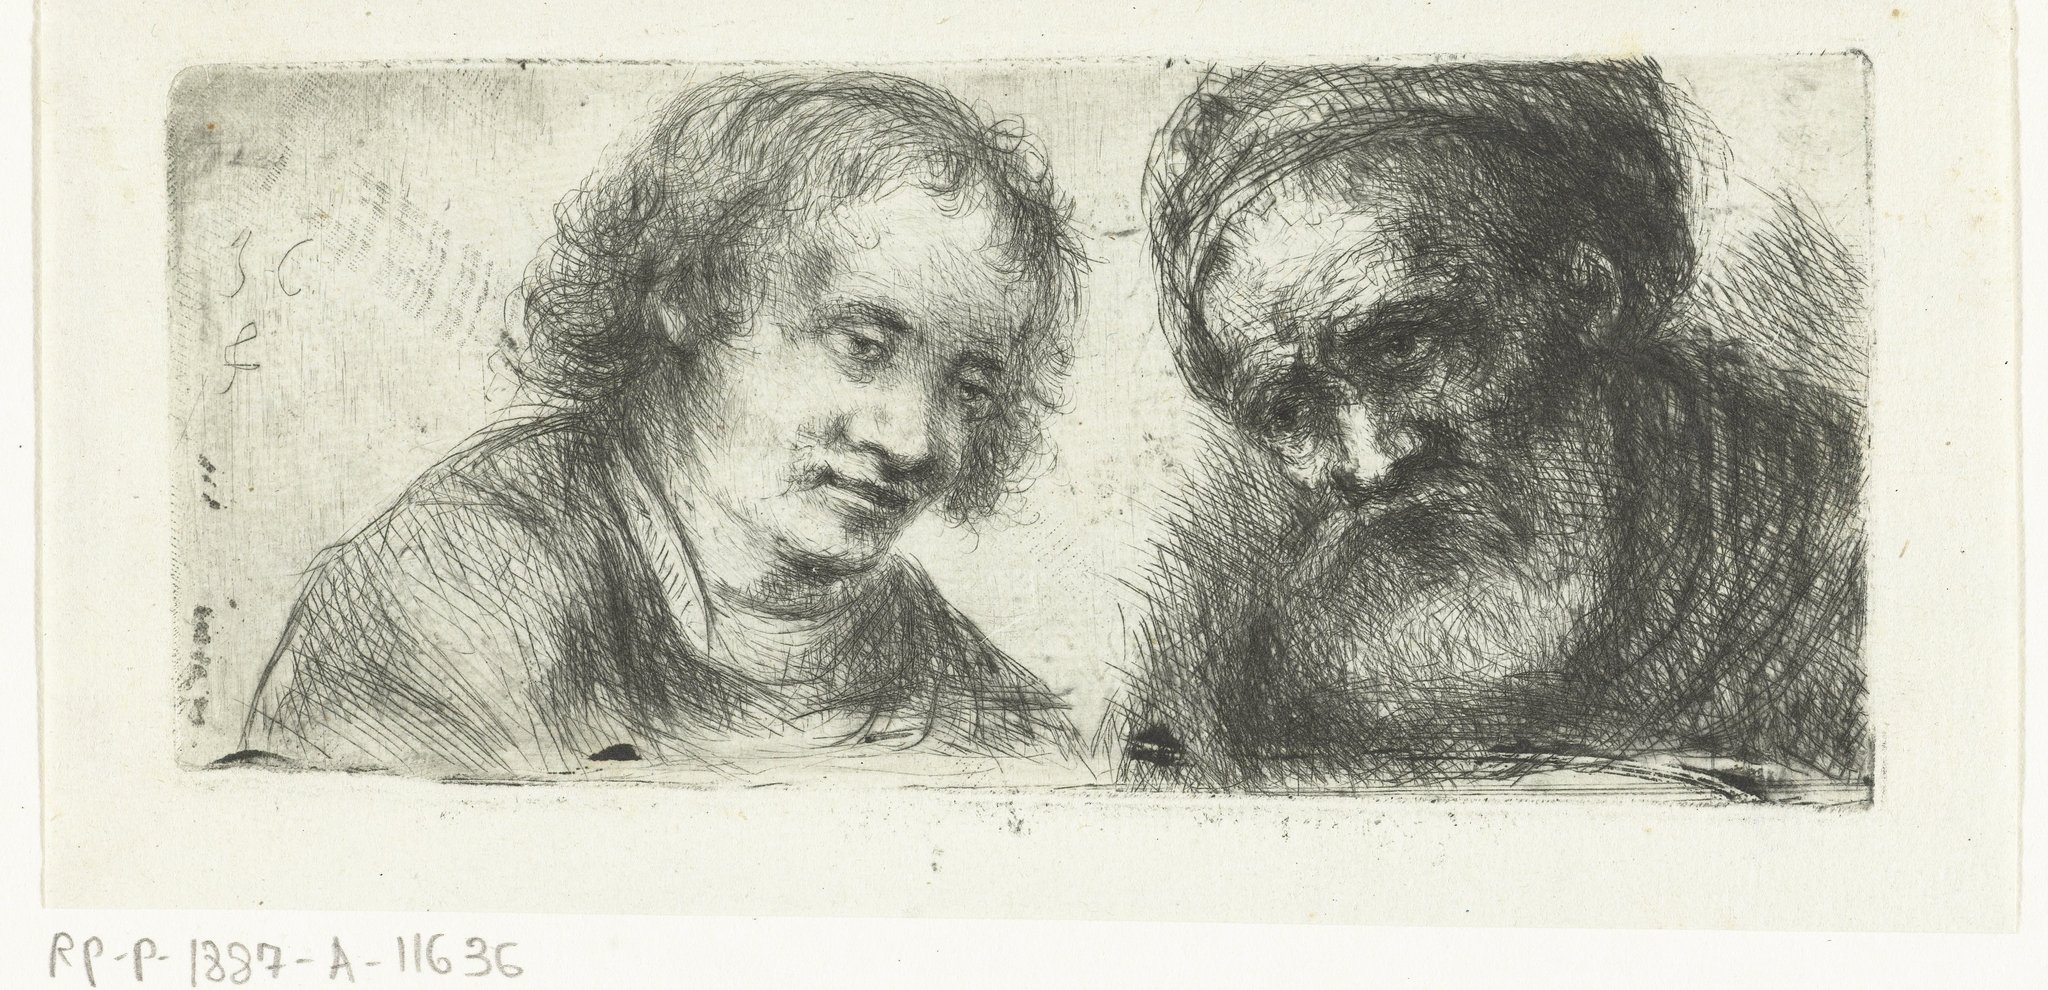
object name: print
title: Jonge en oude man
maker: jan chalon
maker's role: print maker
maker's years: 1738-1795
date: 1748-1795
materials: paper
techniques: drypoint, etching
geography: northern netherlands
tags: morphology of human expression (+ old male (human being)), morphology of human expression (+ young male (human being))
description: Portret van twee mannen. Rechts een oude man met baard. Buste naar links. Links een jongeman. Buste naar rechts.